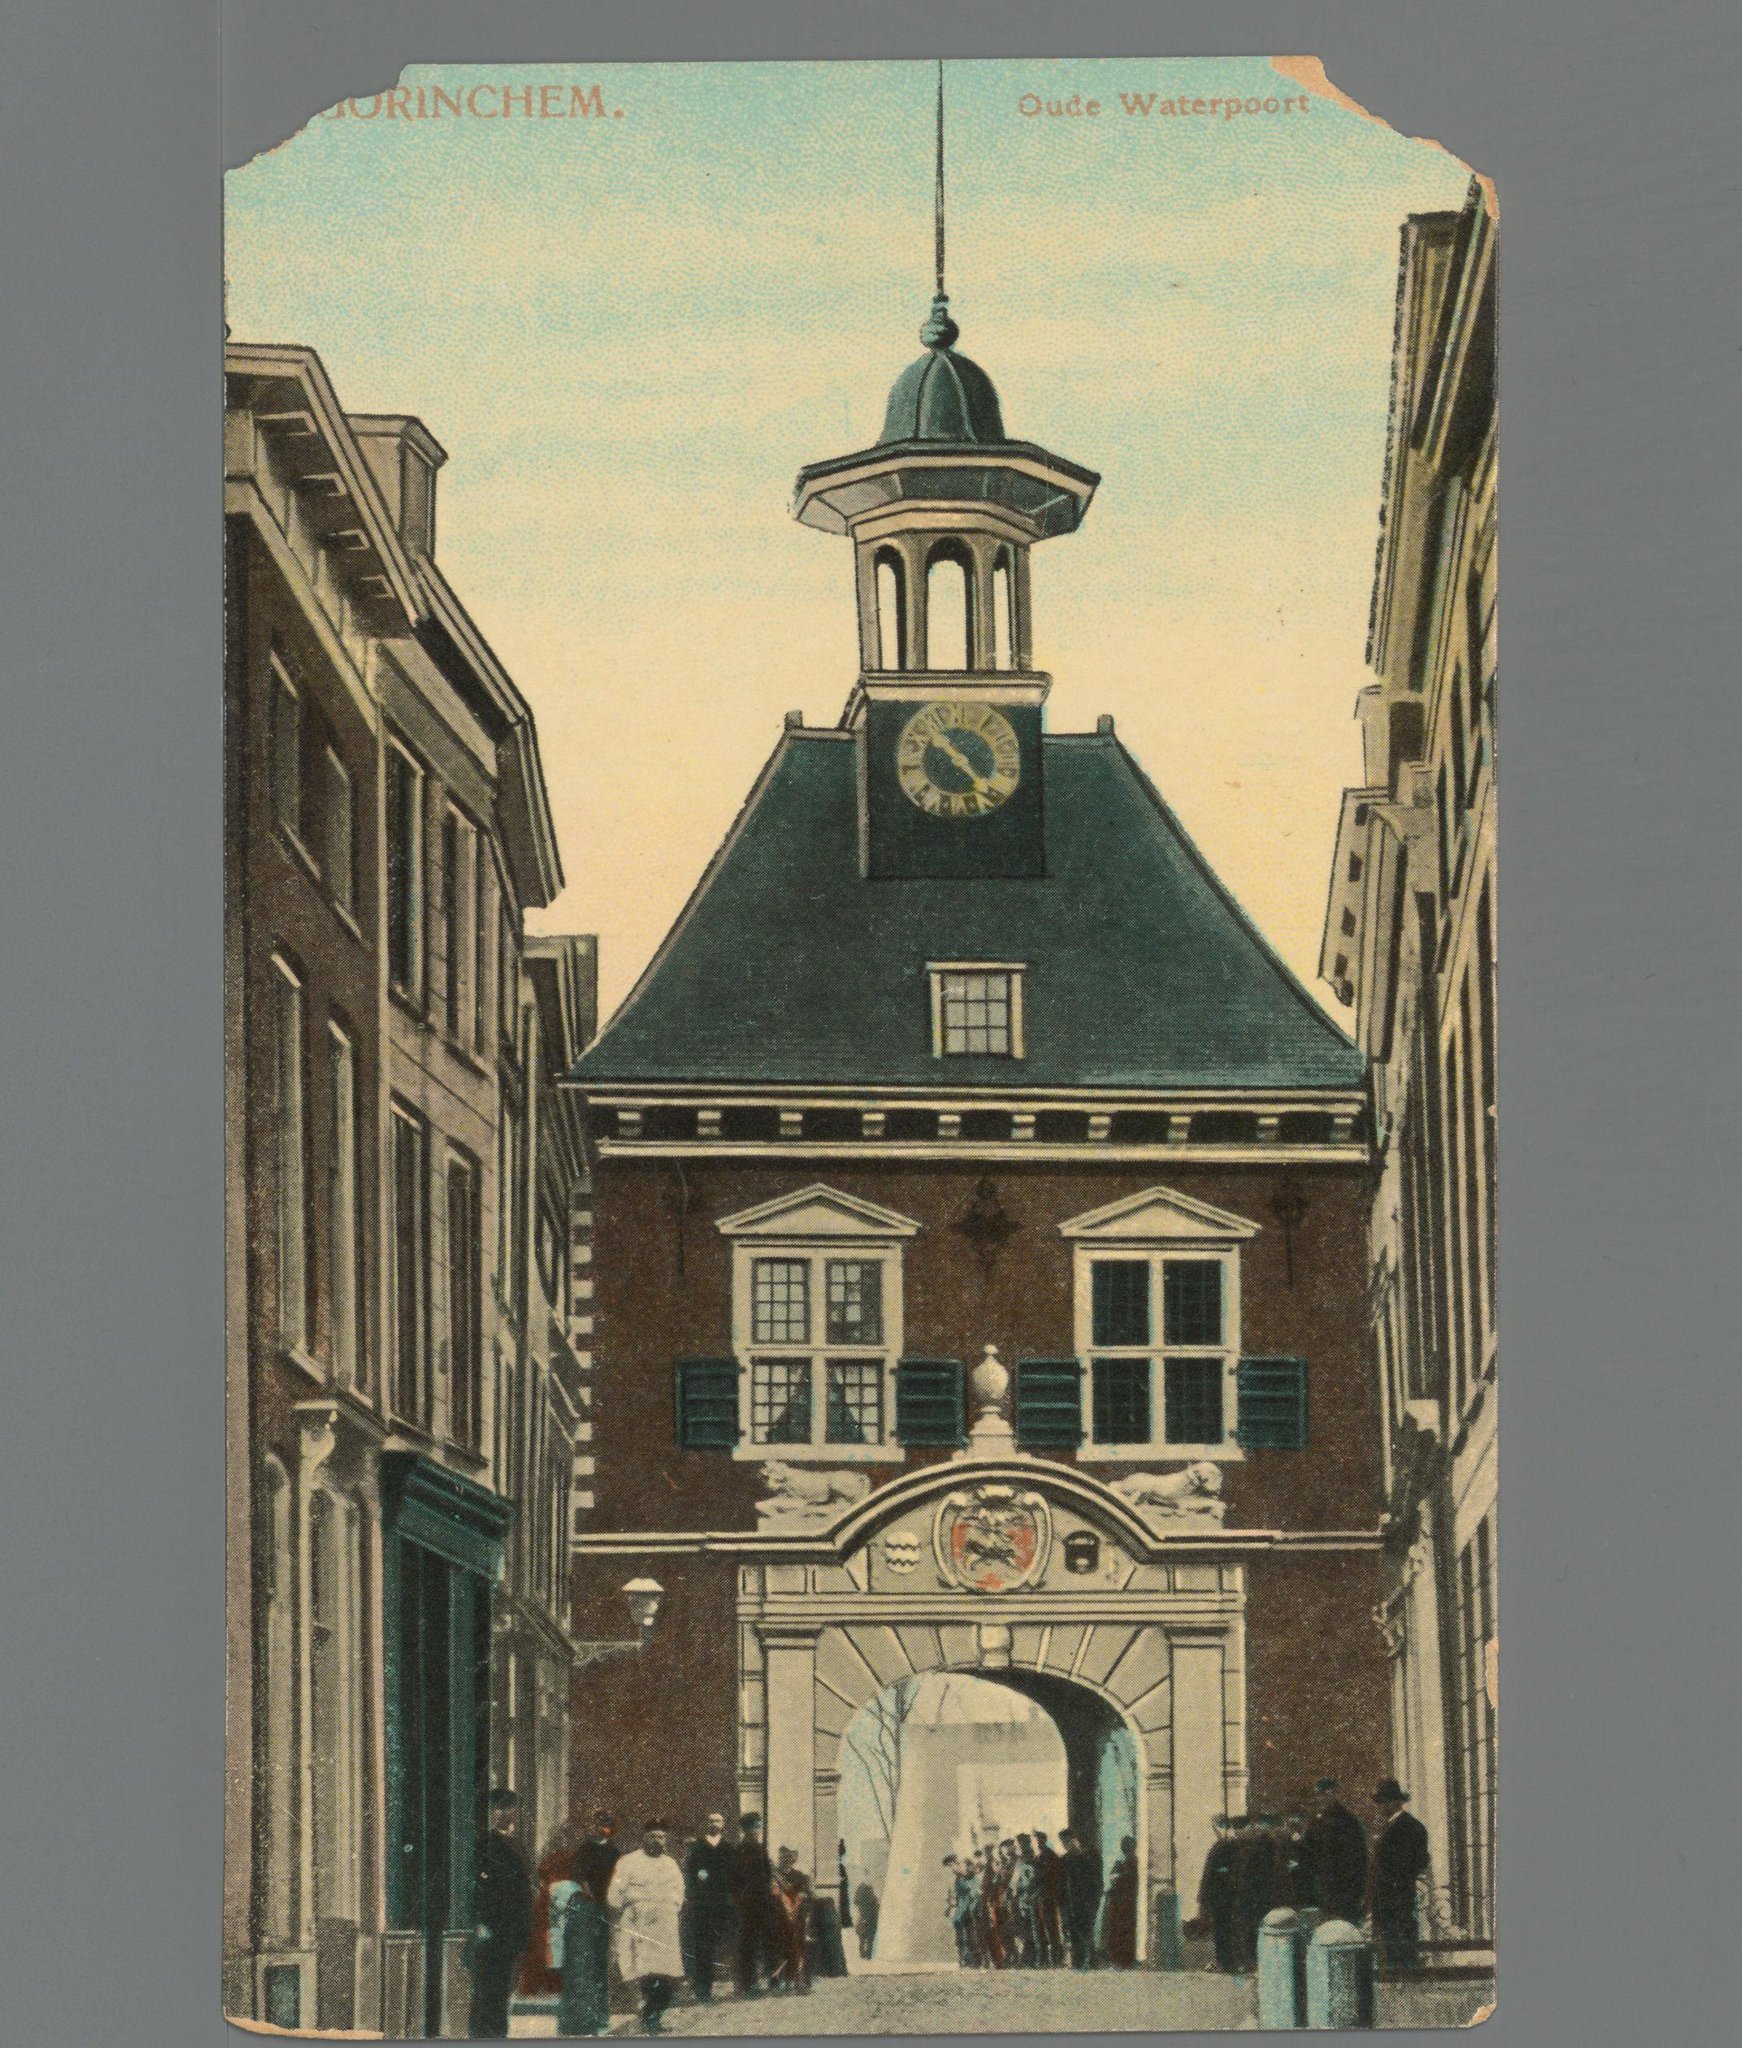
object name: ansichtkaart, prentbriefkaart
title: Gorinchem. Oude Waterpoort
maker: Anonymous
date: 1905-1919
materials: cardboard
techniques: lithograph, writing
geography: gorinchem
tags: city-gate